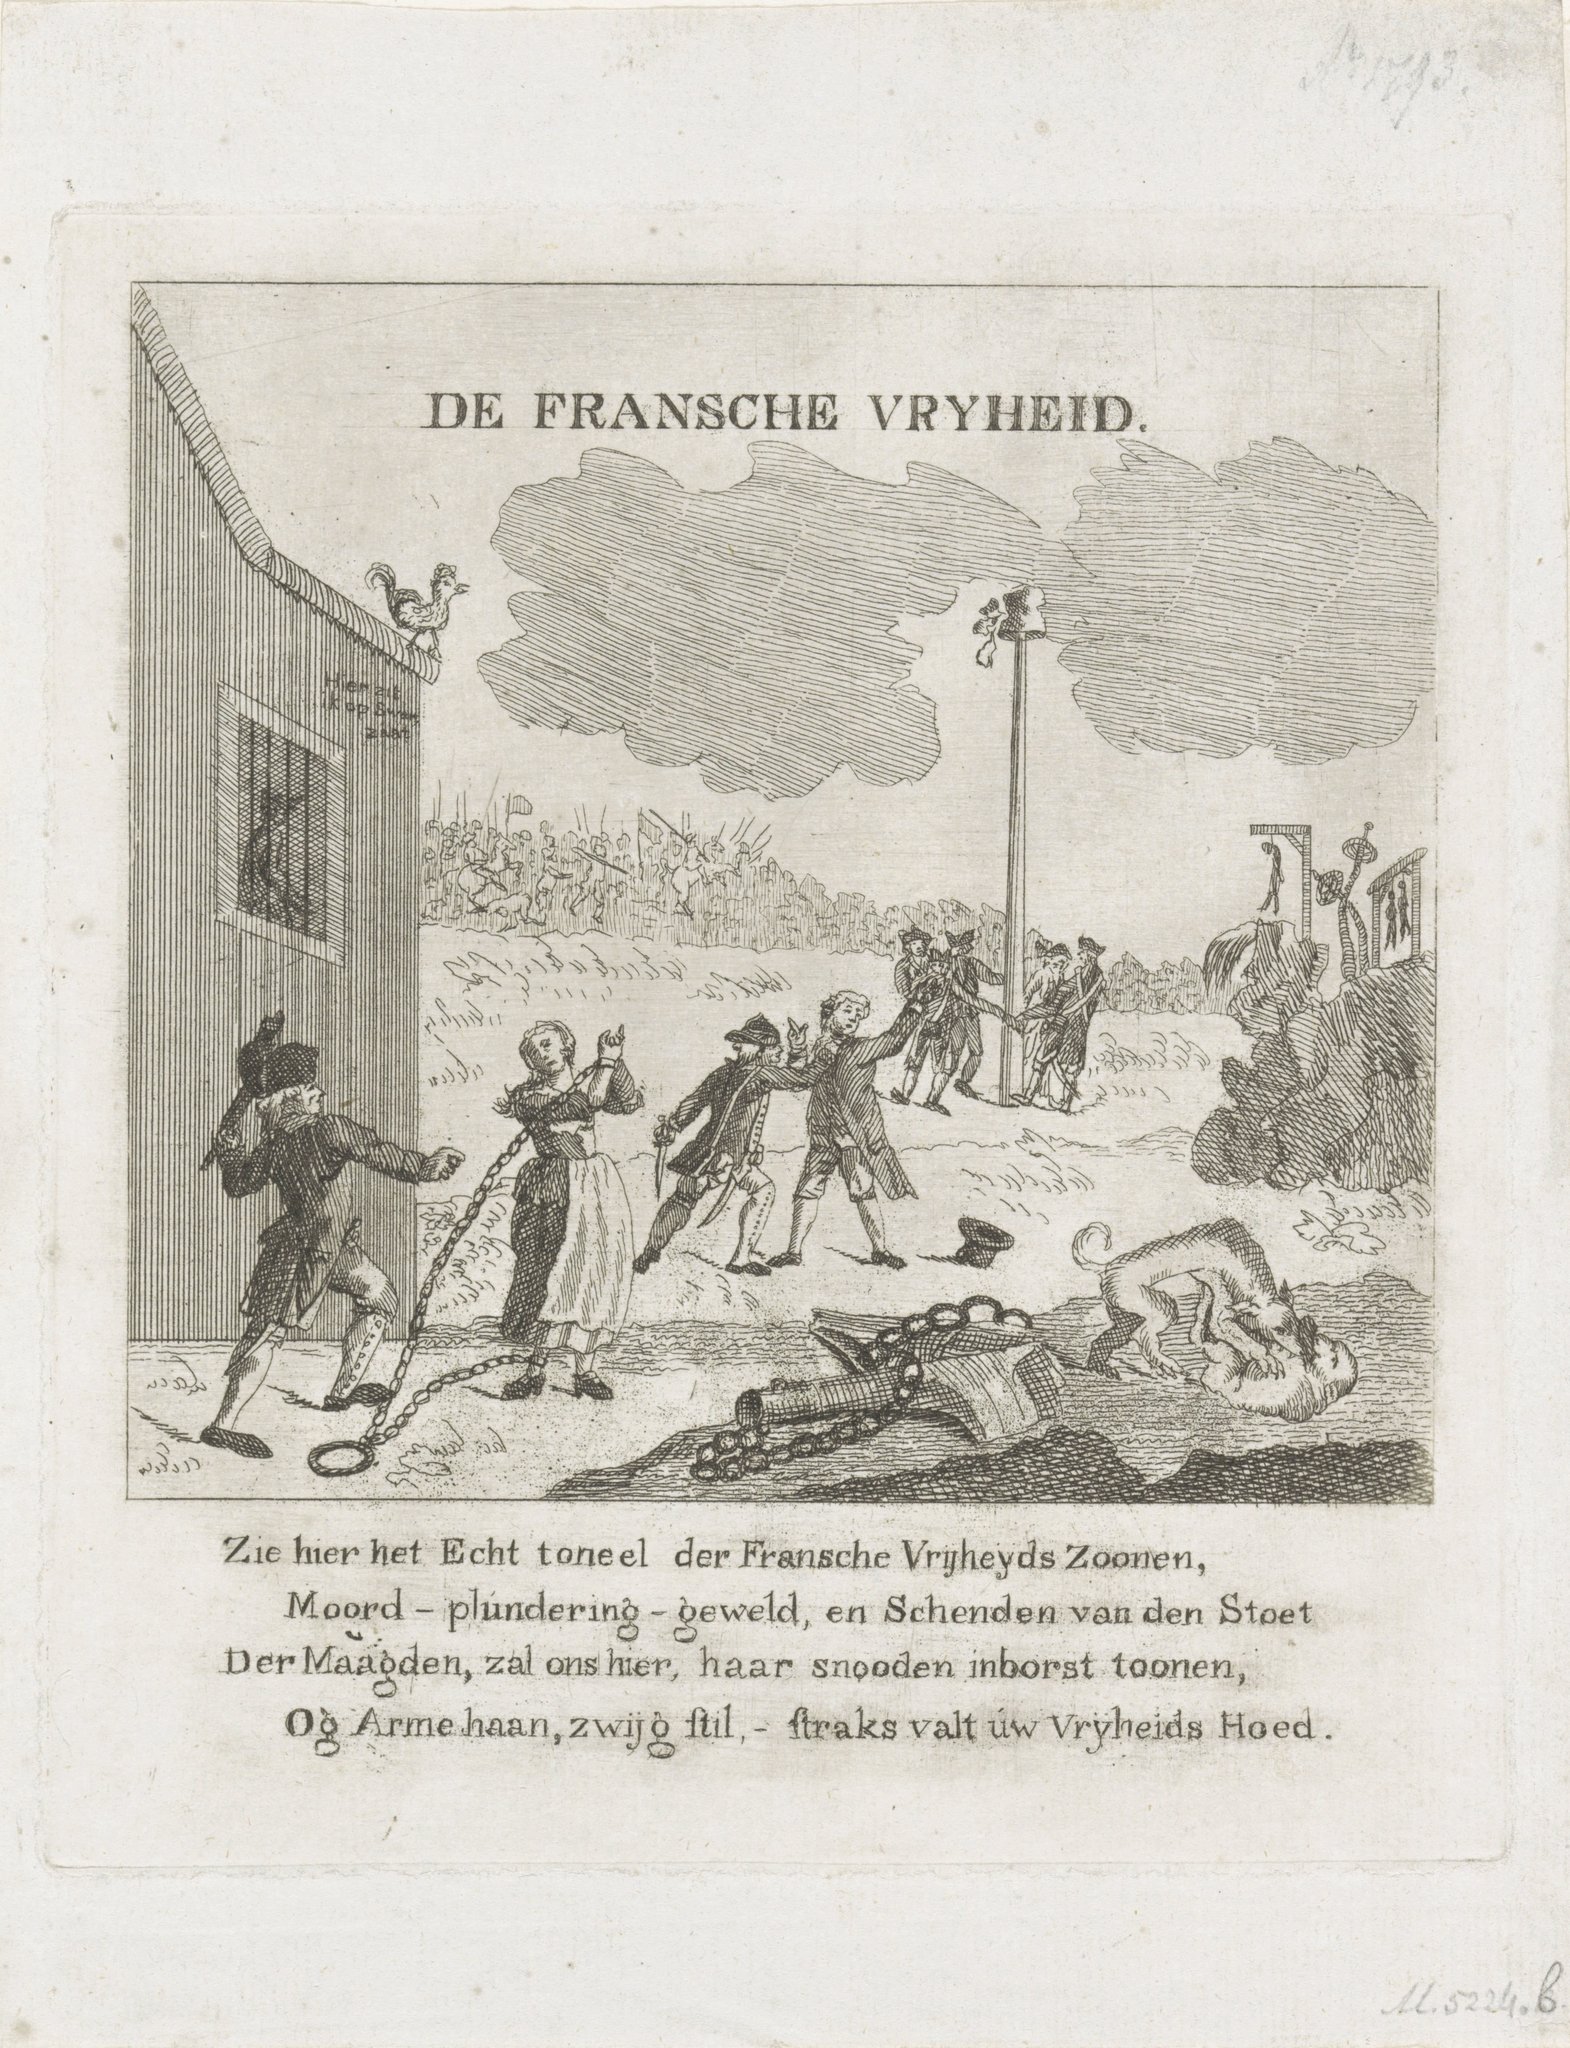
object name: print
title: Franse vrijheid, 1793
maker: Anonymous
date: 1793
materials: paper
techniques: etching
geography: northern netherlands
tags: horrors of war, violent death, being killed; being mishandled and maltreated; seeking death, dancing around the tree of liberty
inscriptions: collector's mark: Lugt 2228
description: Tirannie door de Franse troepen in de Nederlanden, 1793. Een geketende vrouw wordt geslagen, Jacobijnen dansen om een vrijheidsboom, op de achtergrond oorlog en terechtstellingen. In het onderschrift een vers van vier regels.